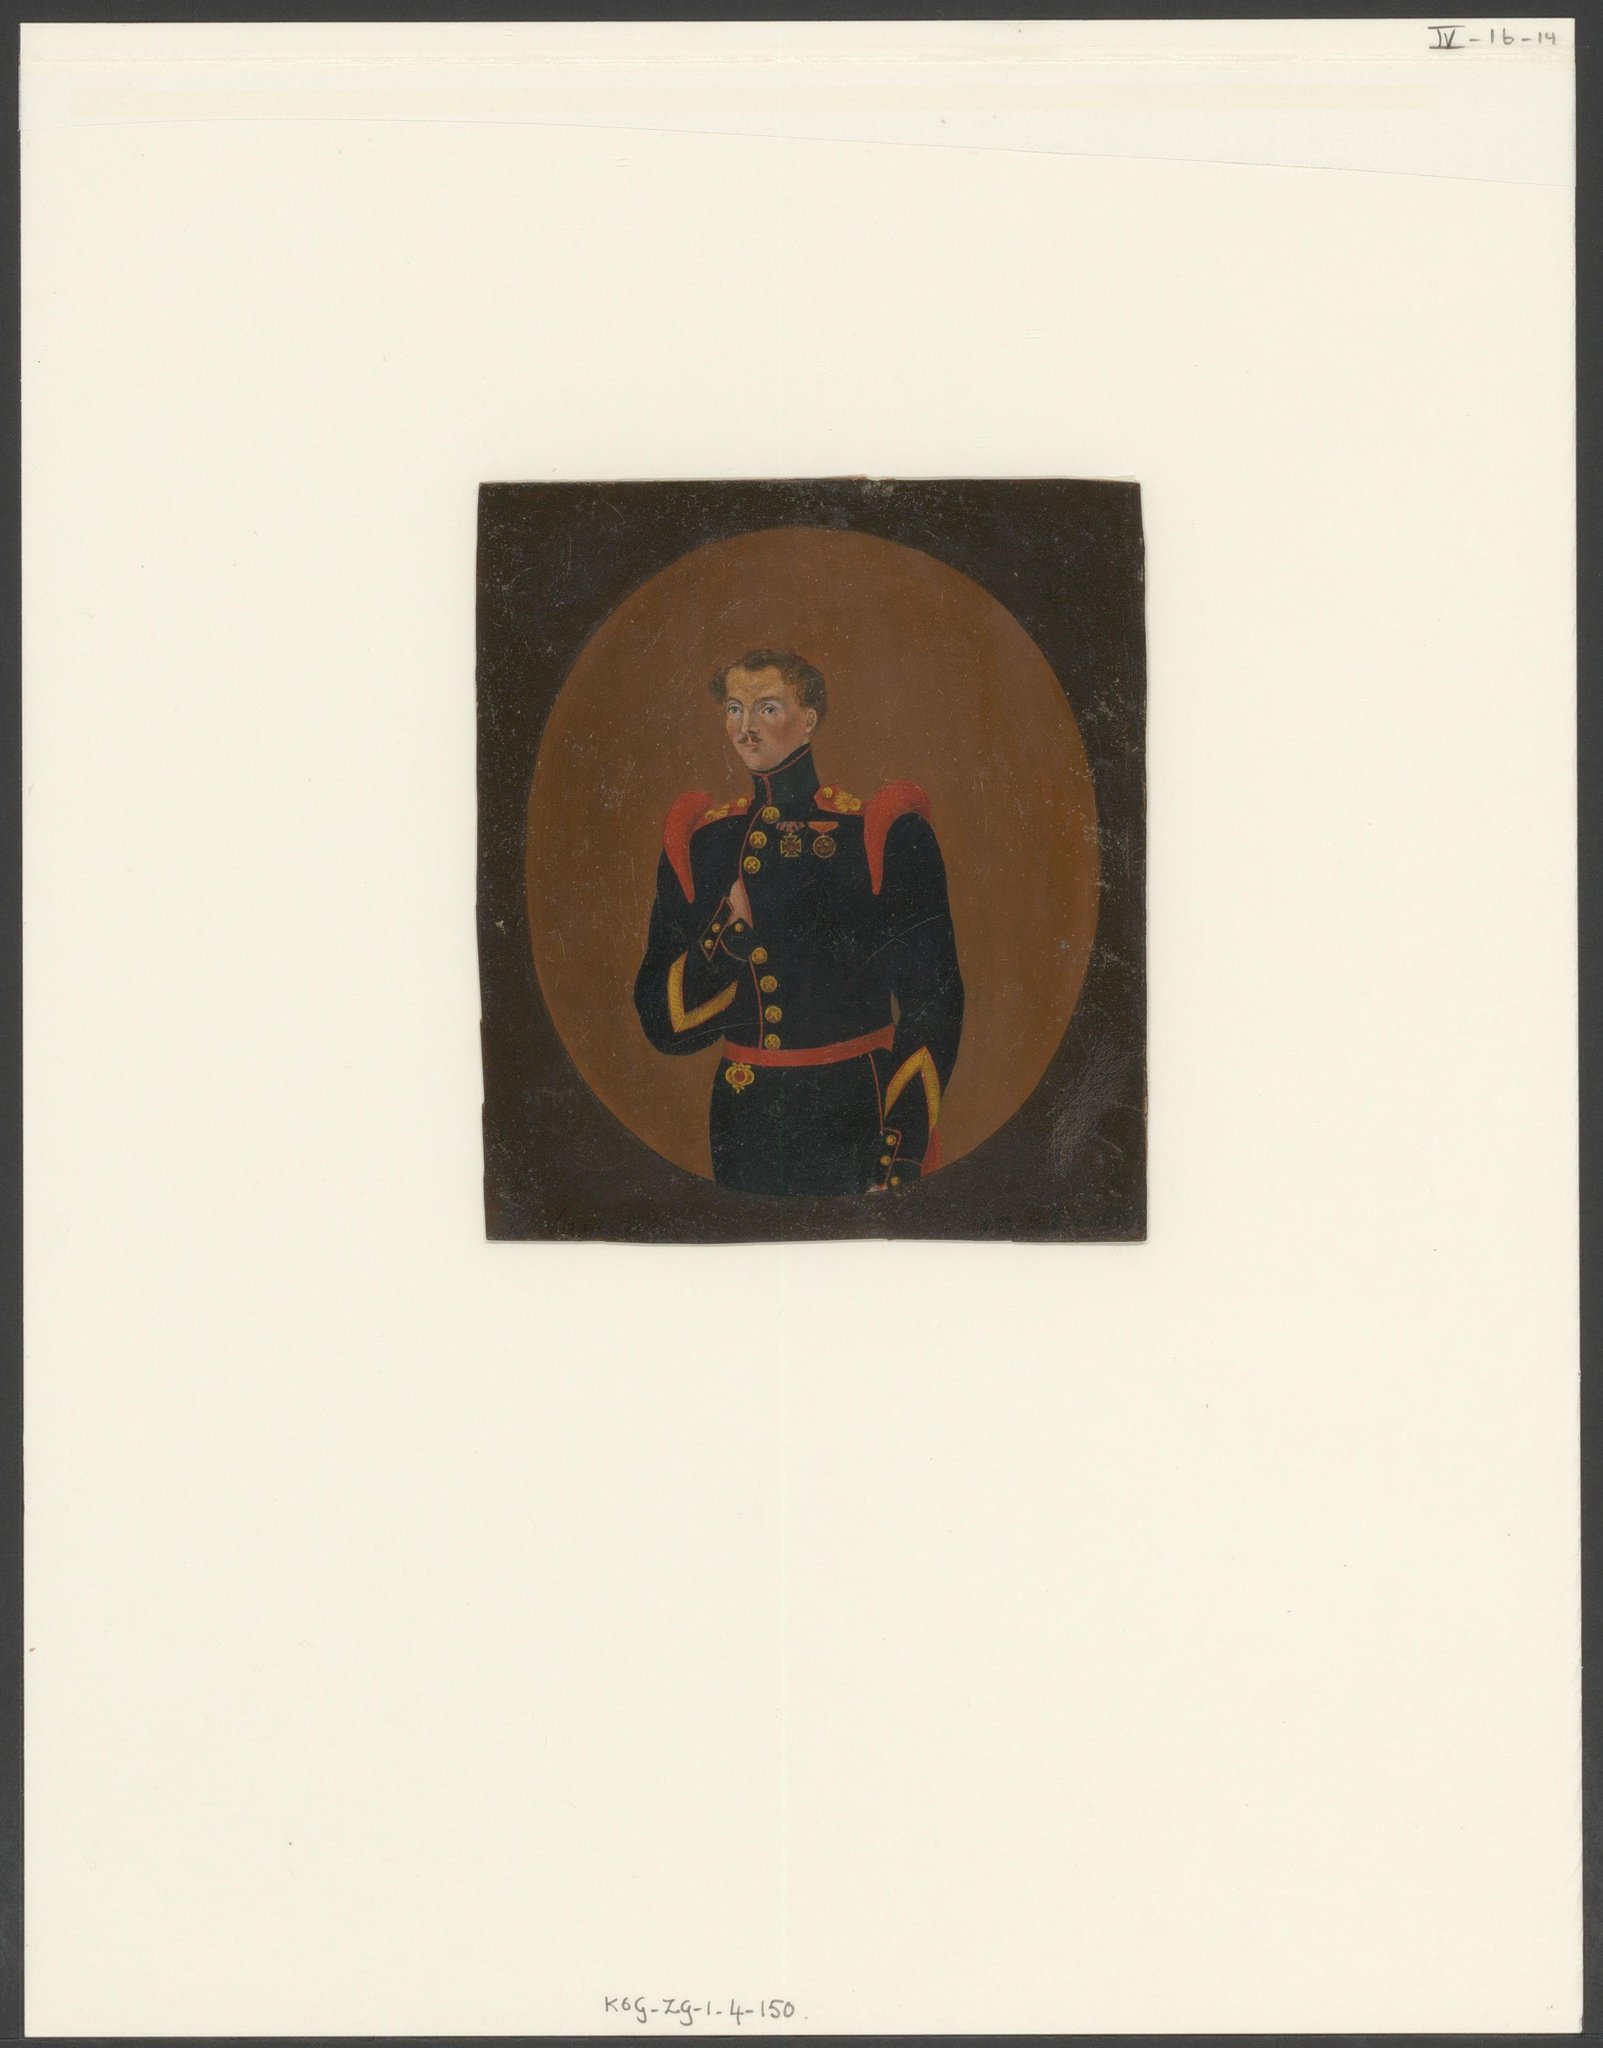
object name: oil painting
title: Portret van Johannes Otto van Setten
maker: Anonymous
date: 1833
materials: cardboard, oil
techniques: brush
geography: maastricht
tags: historical persons, officer, (military) uniforms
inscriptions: inscription: ‘Johannes Otto van Setten / Oud 33 Jaar uitgeschildert / in Maastricht / 1833’